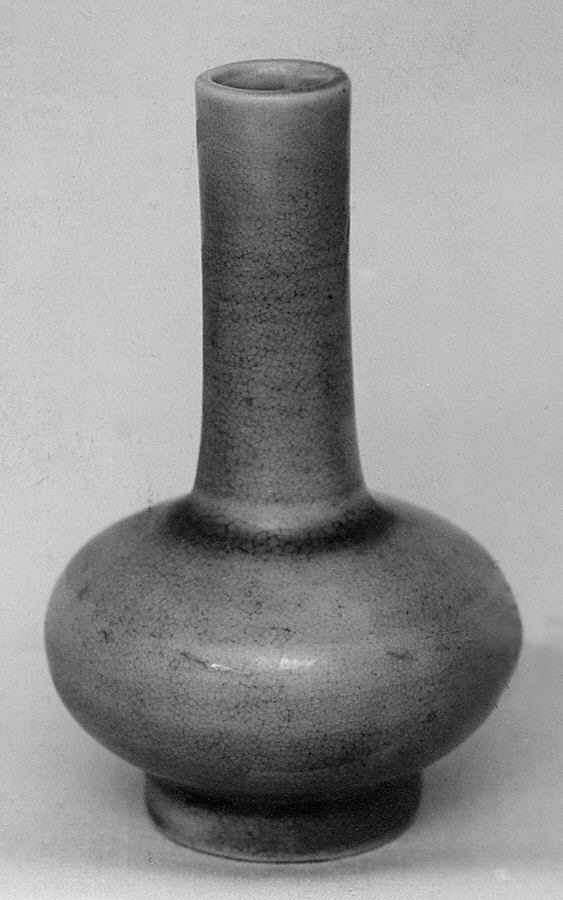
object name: vase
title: Miniature Vase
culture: chinese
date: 1801-1900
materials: porcelain